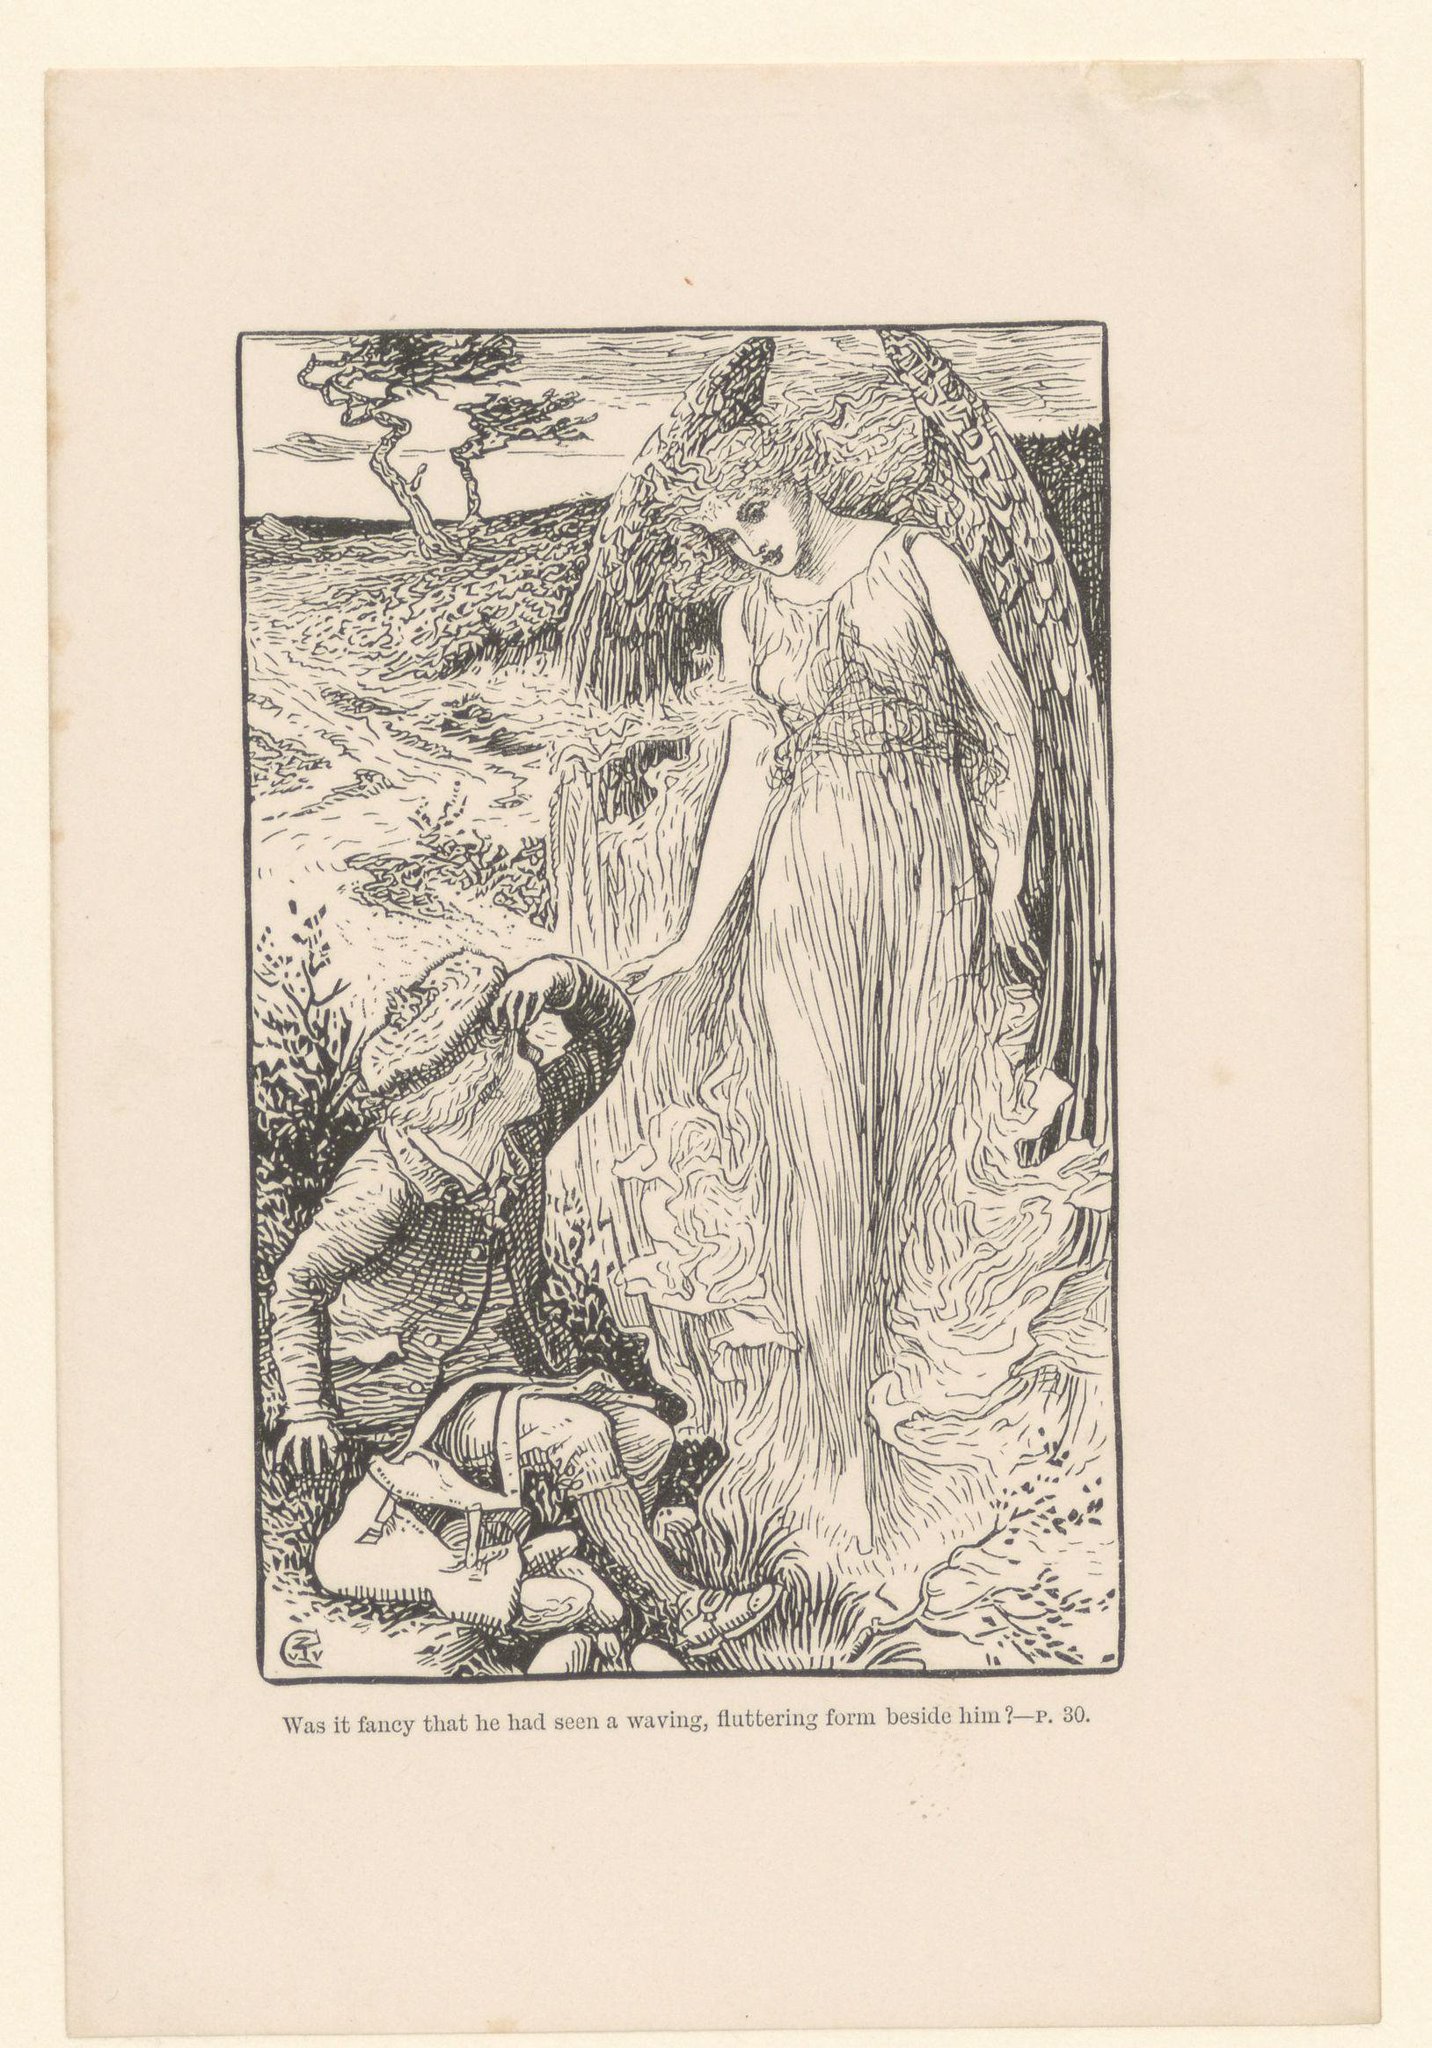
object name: book illustration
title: Landschap met jongen en engel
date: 1887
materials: paper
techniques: letterpress printing, engraving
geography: london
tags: fabulous beings with wings - aa - female human figure, boy (child between toddler and youth)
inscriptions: collector's mark: Lugt 2228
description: Prent uit: Molesworth. Four winds farm. Londen: MacMillan & Co., 1887, p. 30.